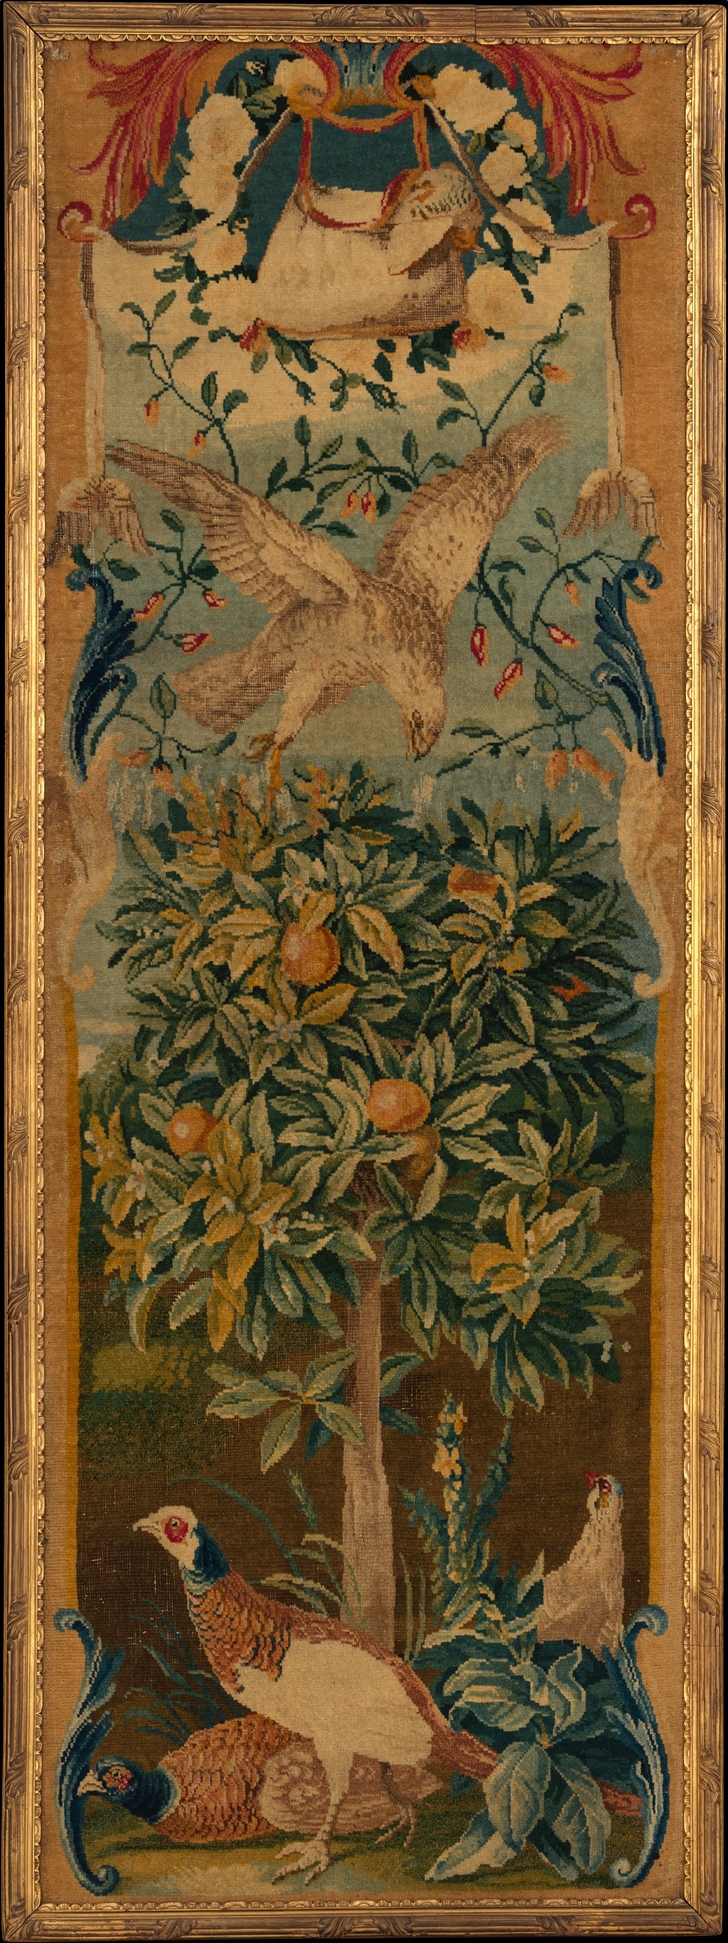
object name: screen panel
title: Hawk and three pheasants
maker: savonnerie manufactory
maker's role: manufactory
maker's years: 1626-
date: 1719-1772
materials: wool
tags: hawks,fruit,pheasants,flowers,trees